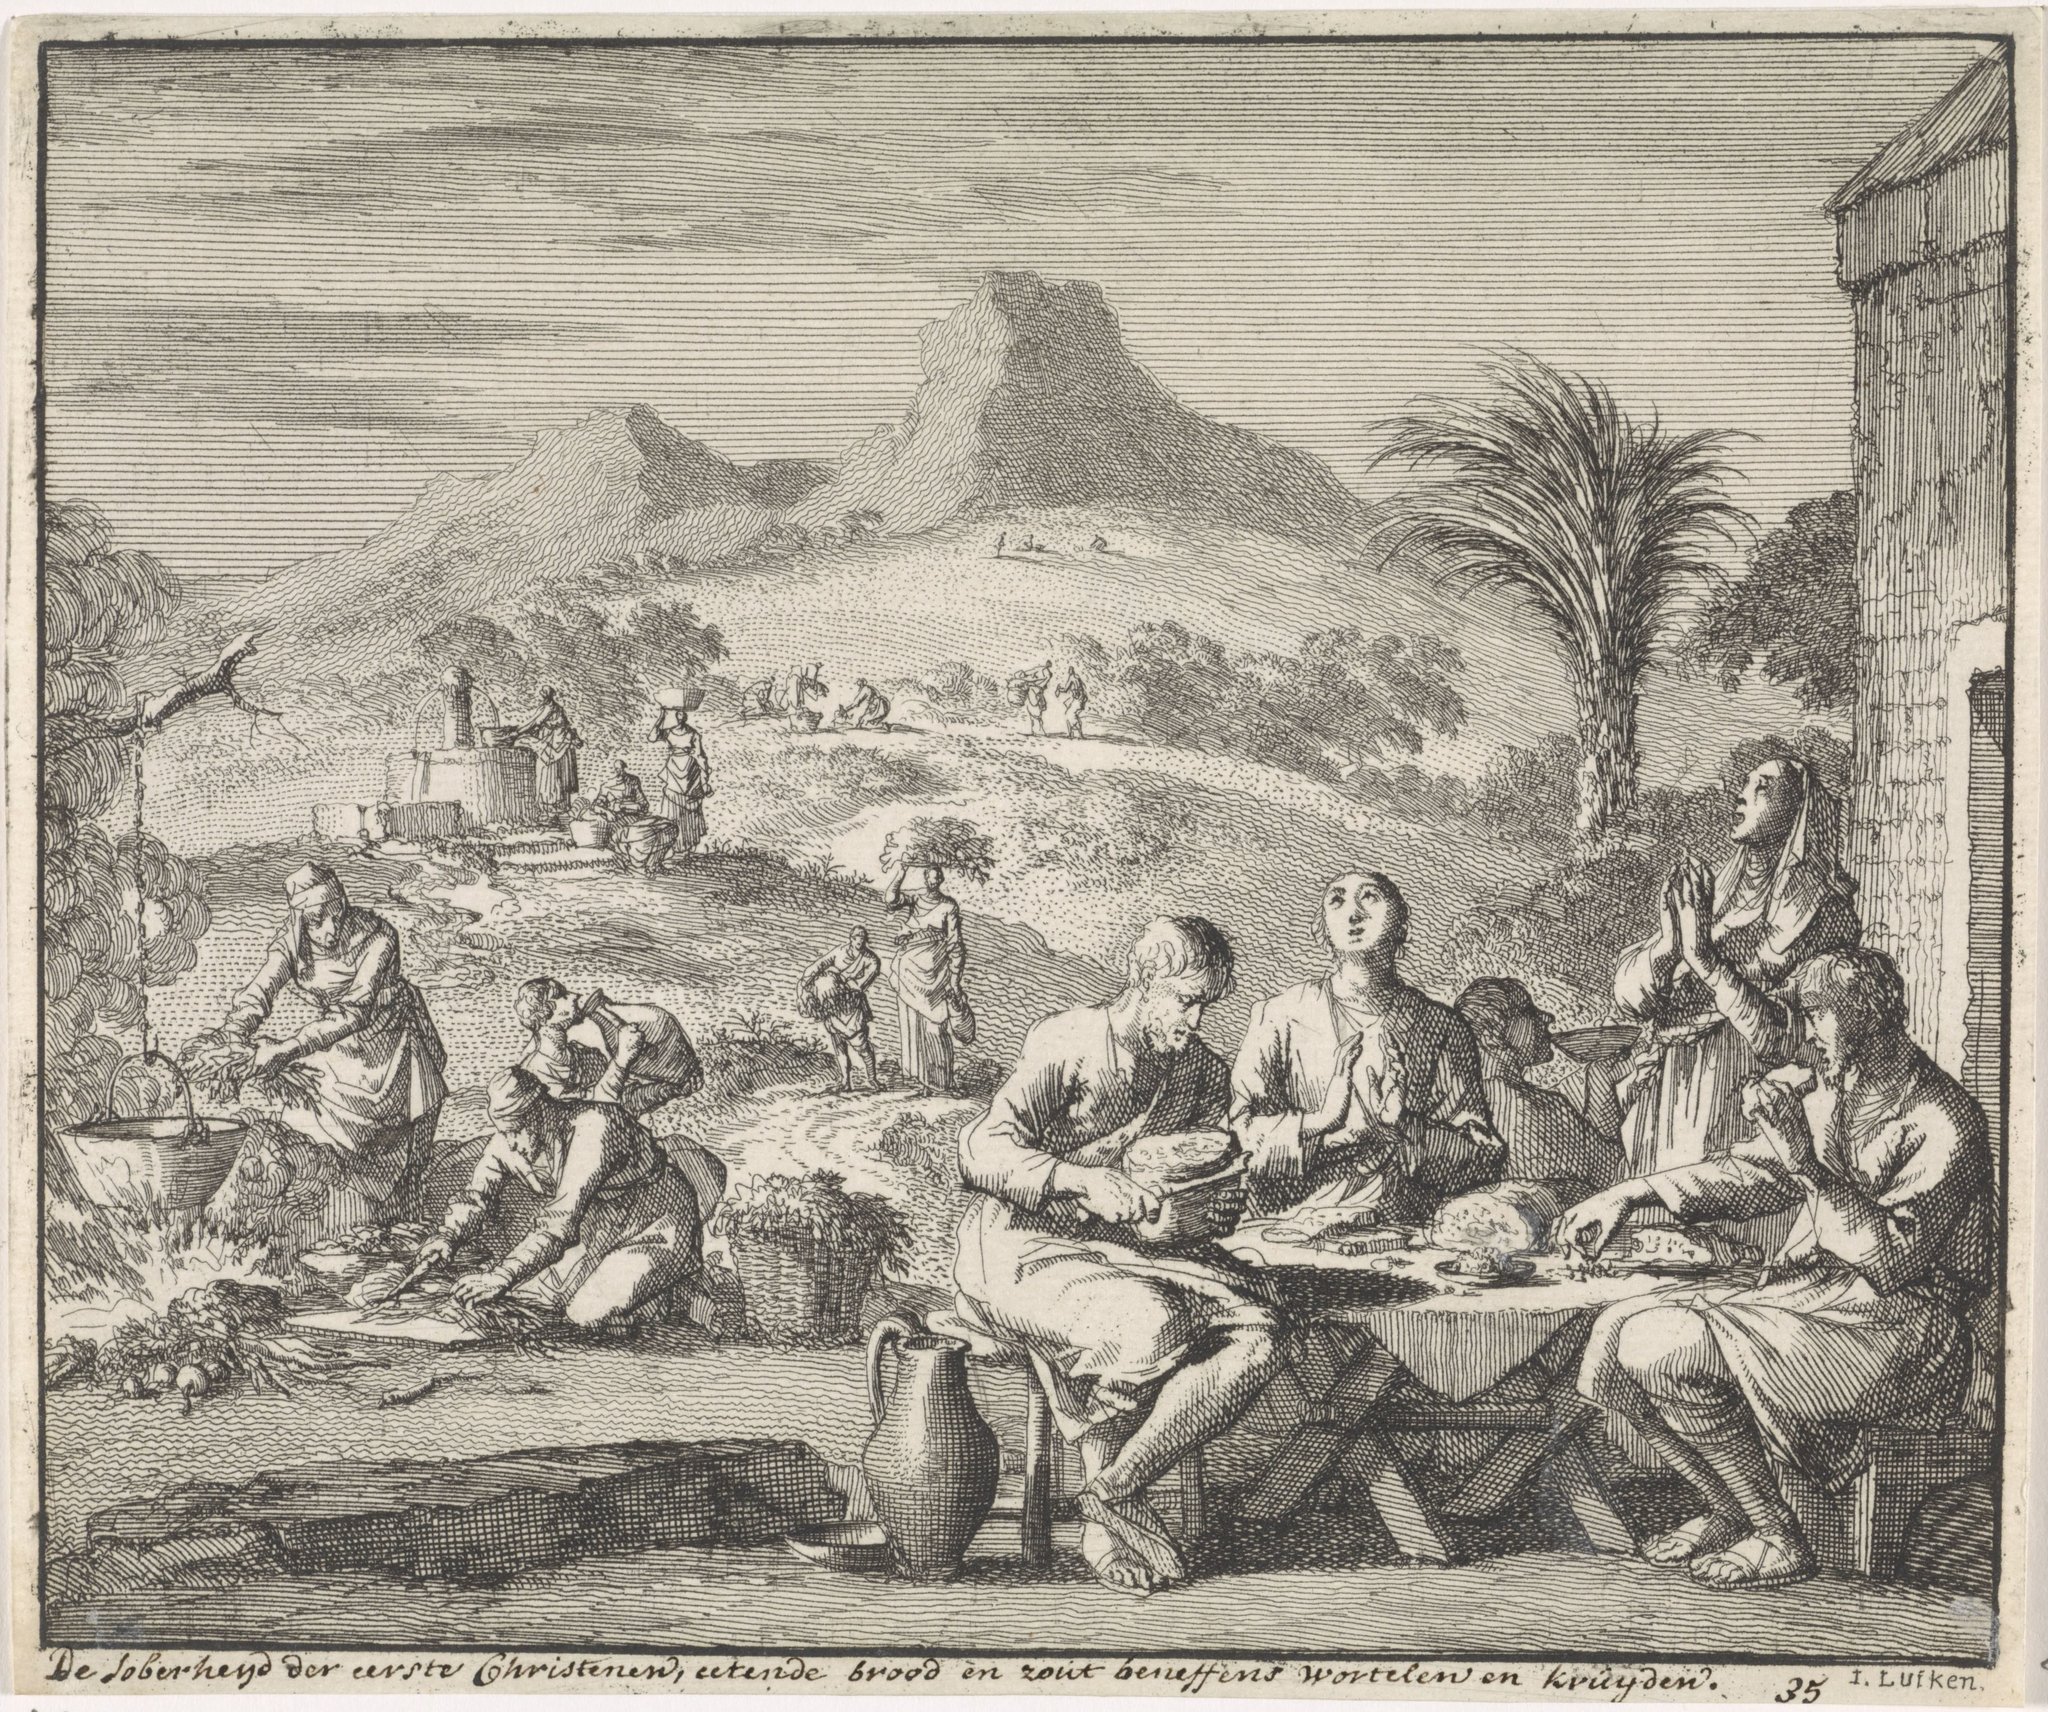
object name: print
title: Sobere maaltijd van de eerste christenen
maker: jan luyken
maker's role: draughtsman, print maker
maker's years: 1649-1712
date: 1700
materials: paper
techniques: etching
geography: amsterdam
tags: the early christian churches, e.g. armenians, copts, syrians, bread, loaf, evening meal, dinner, supper, broth, soup, utilitarian, public pump or water fountain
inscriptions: collector's mark: Lugt 2228, number: ‘35’, caption: ‘De soberheijd der eerste Christenen, eetende brood en zout beneffens wortelen en kruyden’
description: Op de voorgrond zitten enkele vroege christenen rond een tafel. Ze danken God voor de eenvoudige maaltijd en eten brood. Op de achtergrond wordt soep gekookt en wordt water uit een bron gehaald.